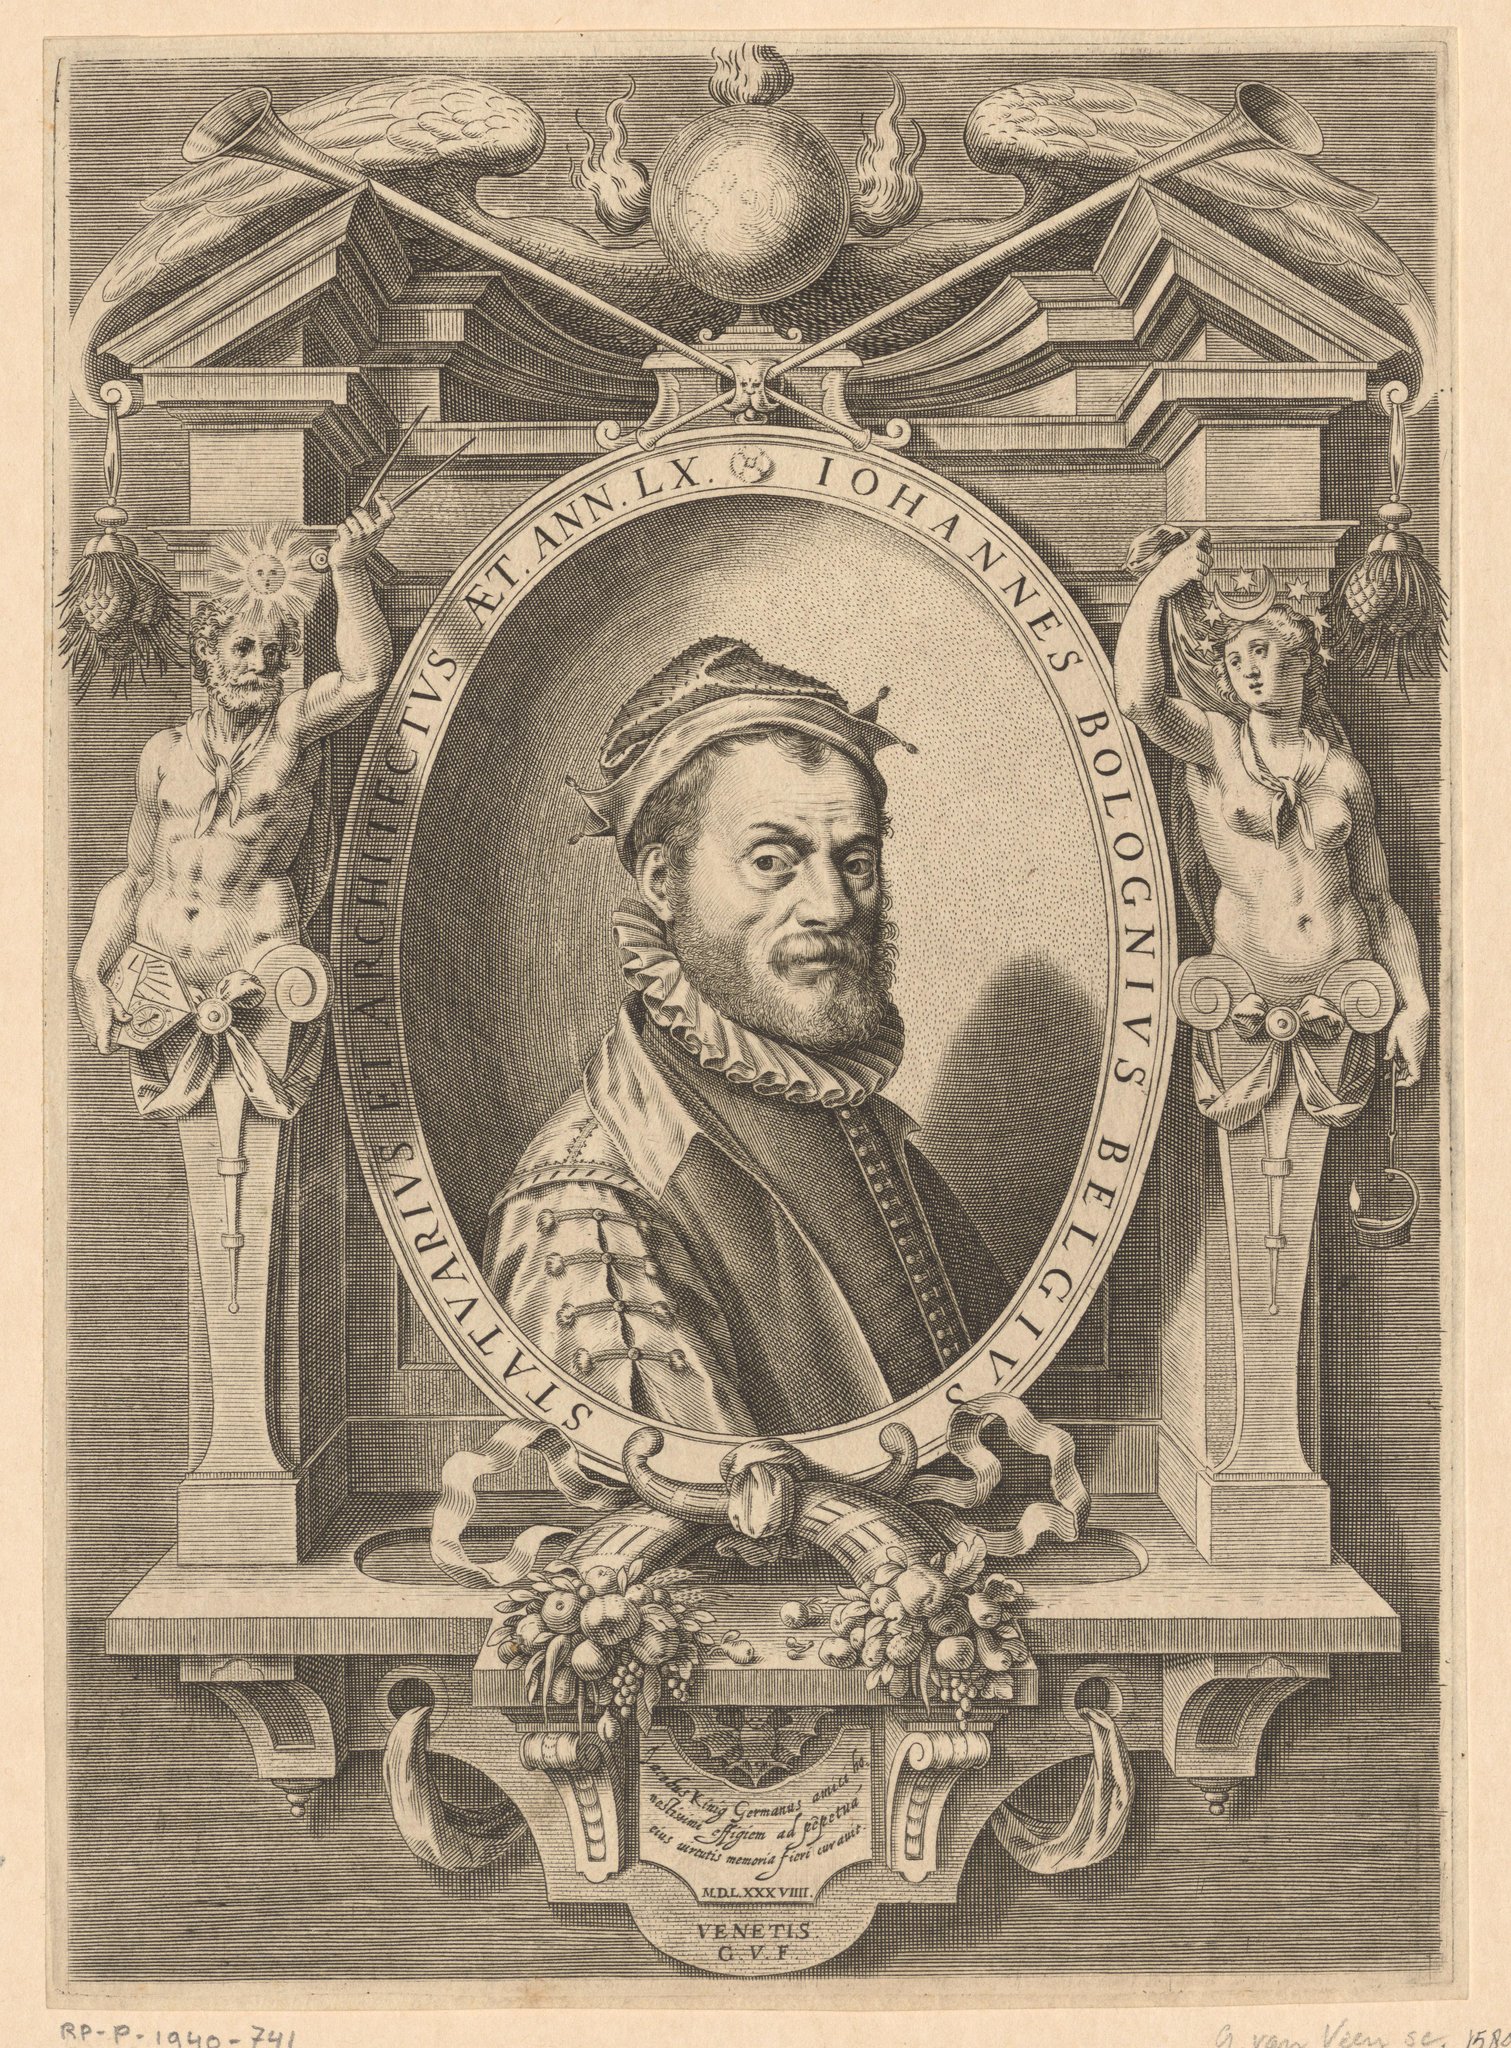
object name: print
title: Portret van Giambologna op 60-jarige leeftijd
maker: gijsbert van veen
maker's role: print maker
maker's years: 1562-1628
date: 1589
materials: paper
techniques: engraving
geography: venice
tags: draughtsman, goldsmith, sculptor, giambologna, portrait, self-portrait of sculptor, historical persons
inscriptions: collector's mark: Lugt 2228, collector's mark: Lugt 2760